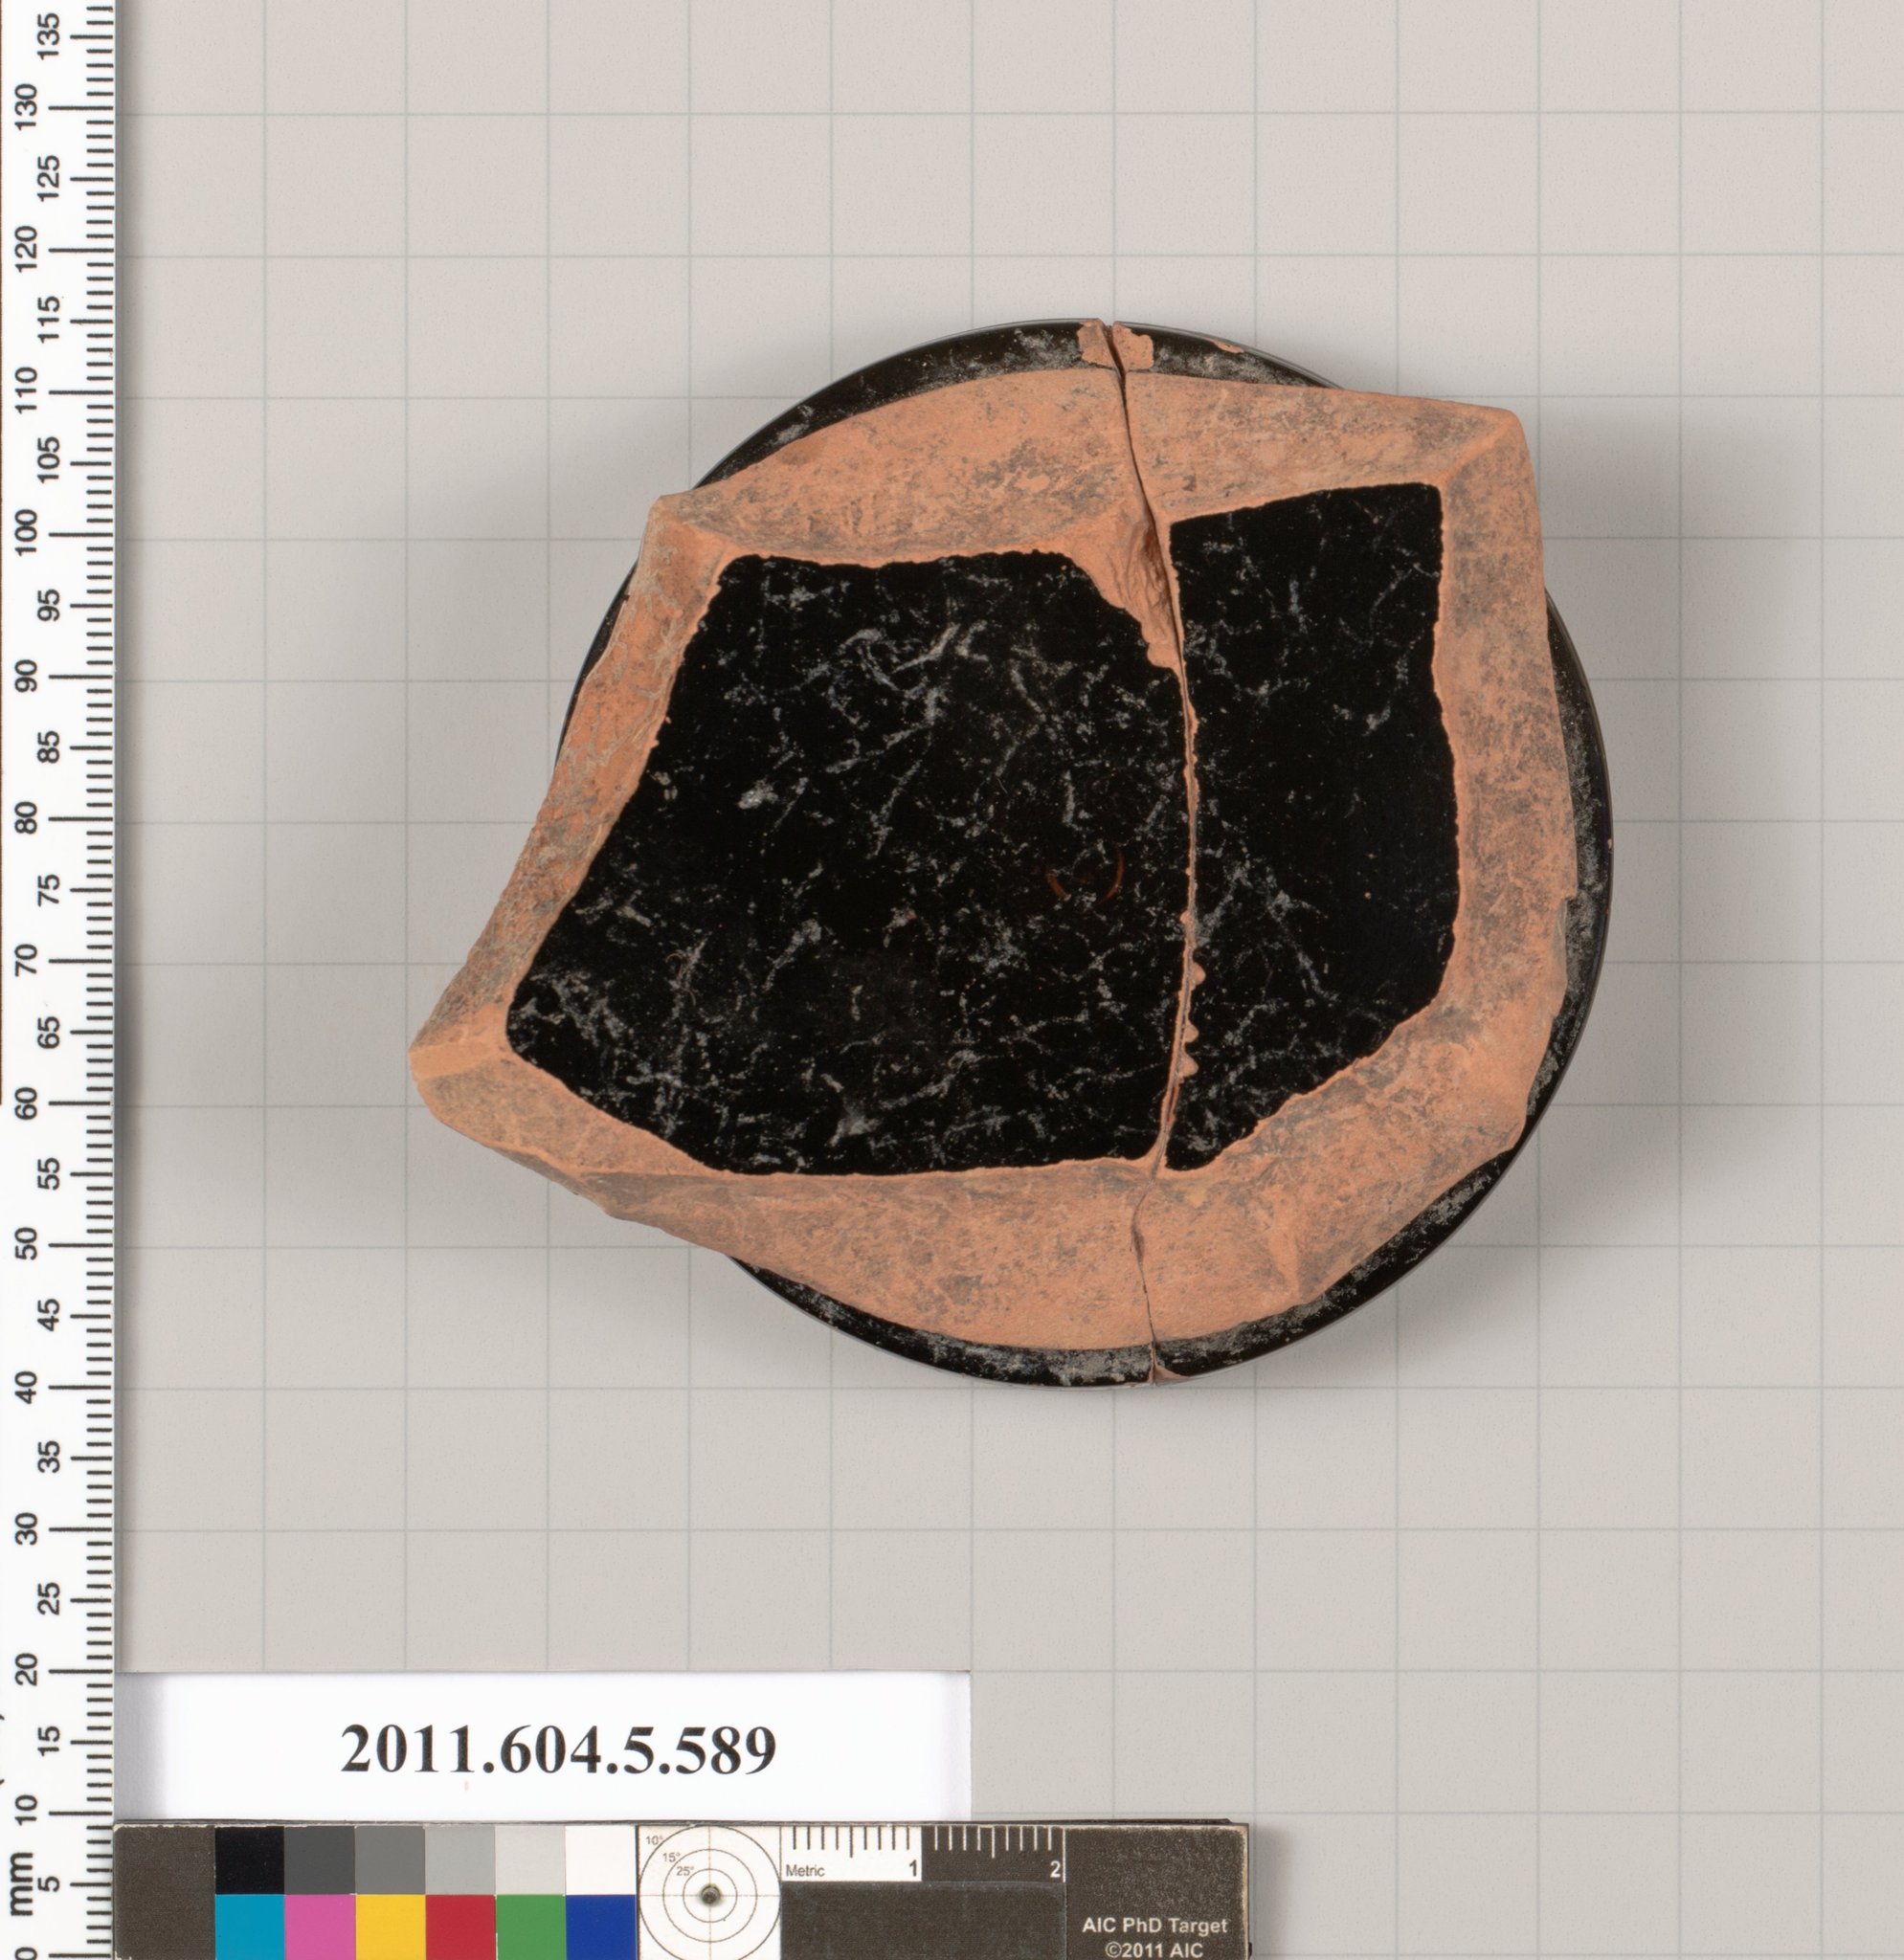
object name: stemless kylix fragment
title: Terracotta fragment of a stemless kylix (drinking cup)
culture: greek, attic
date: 600-401 BCE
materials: terracotta